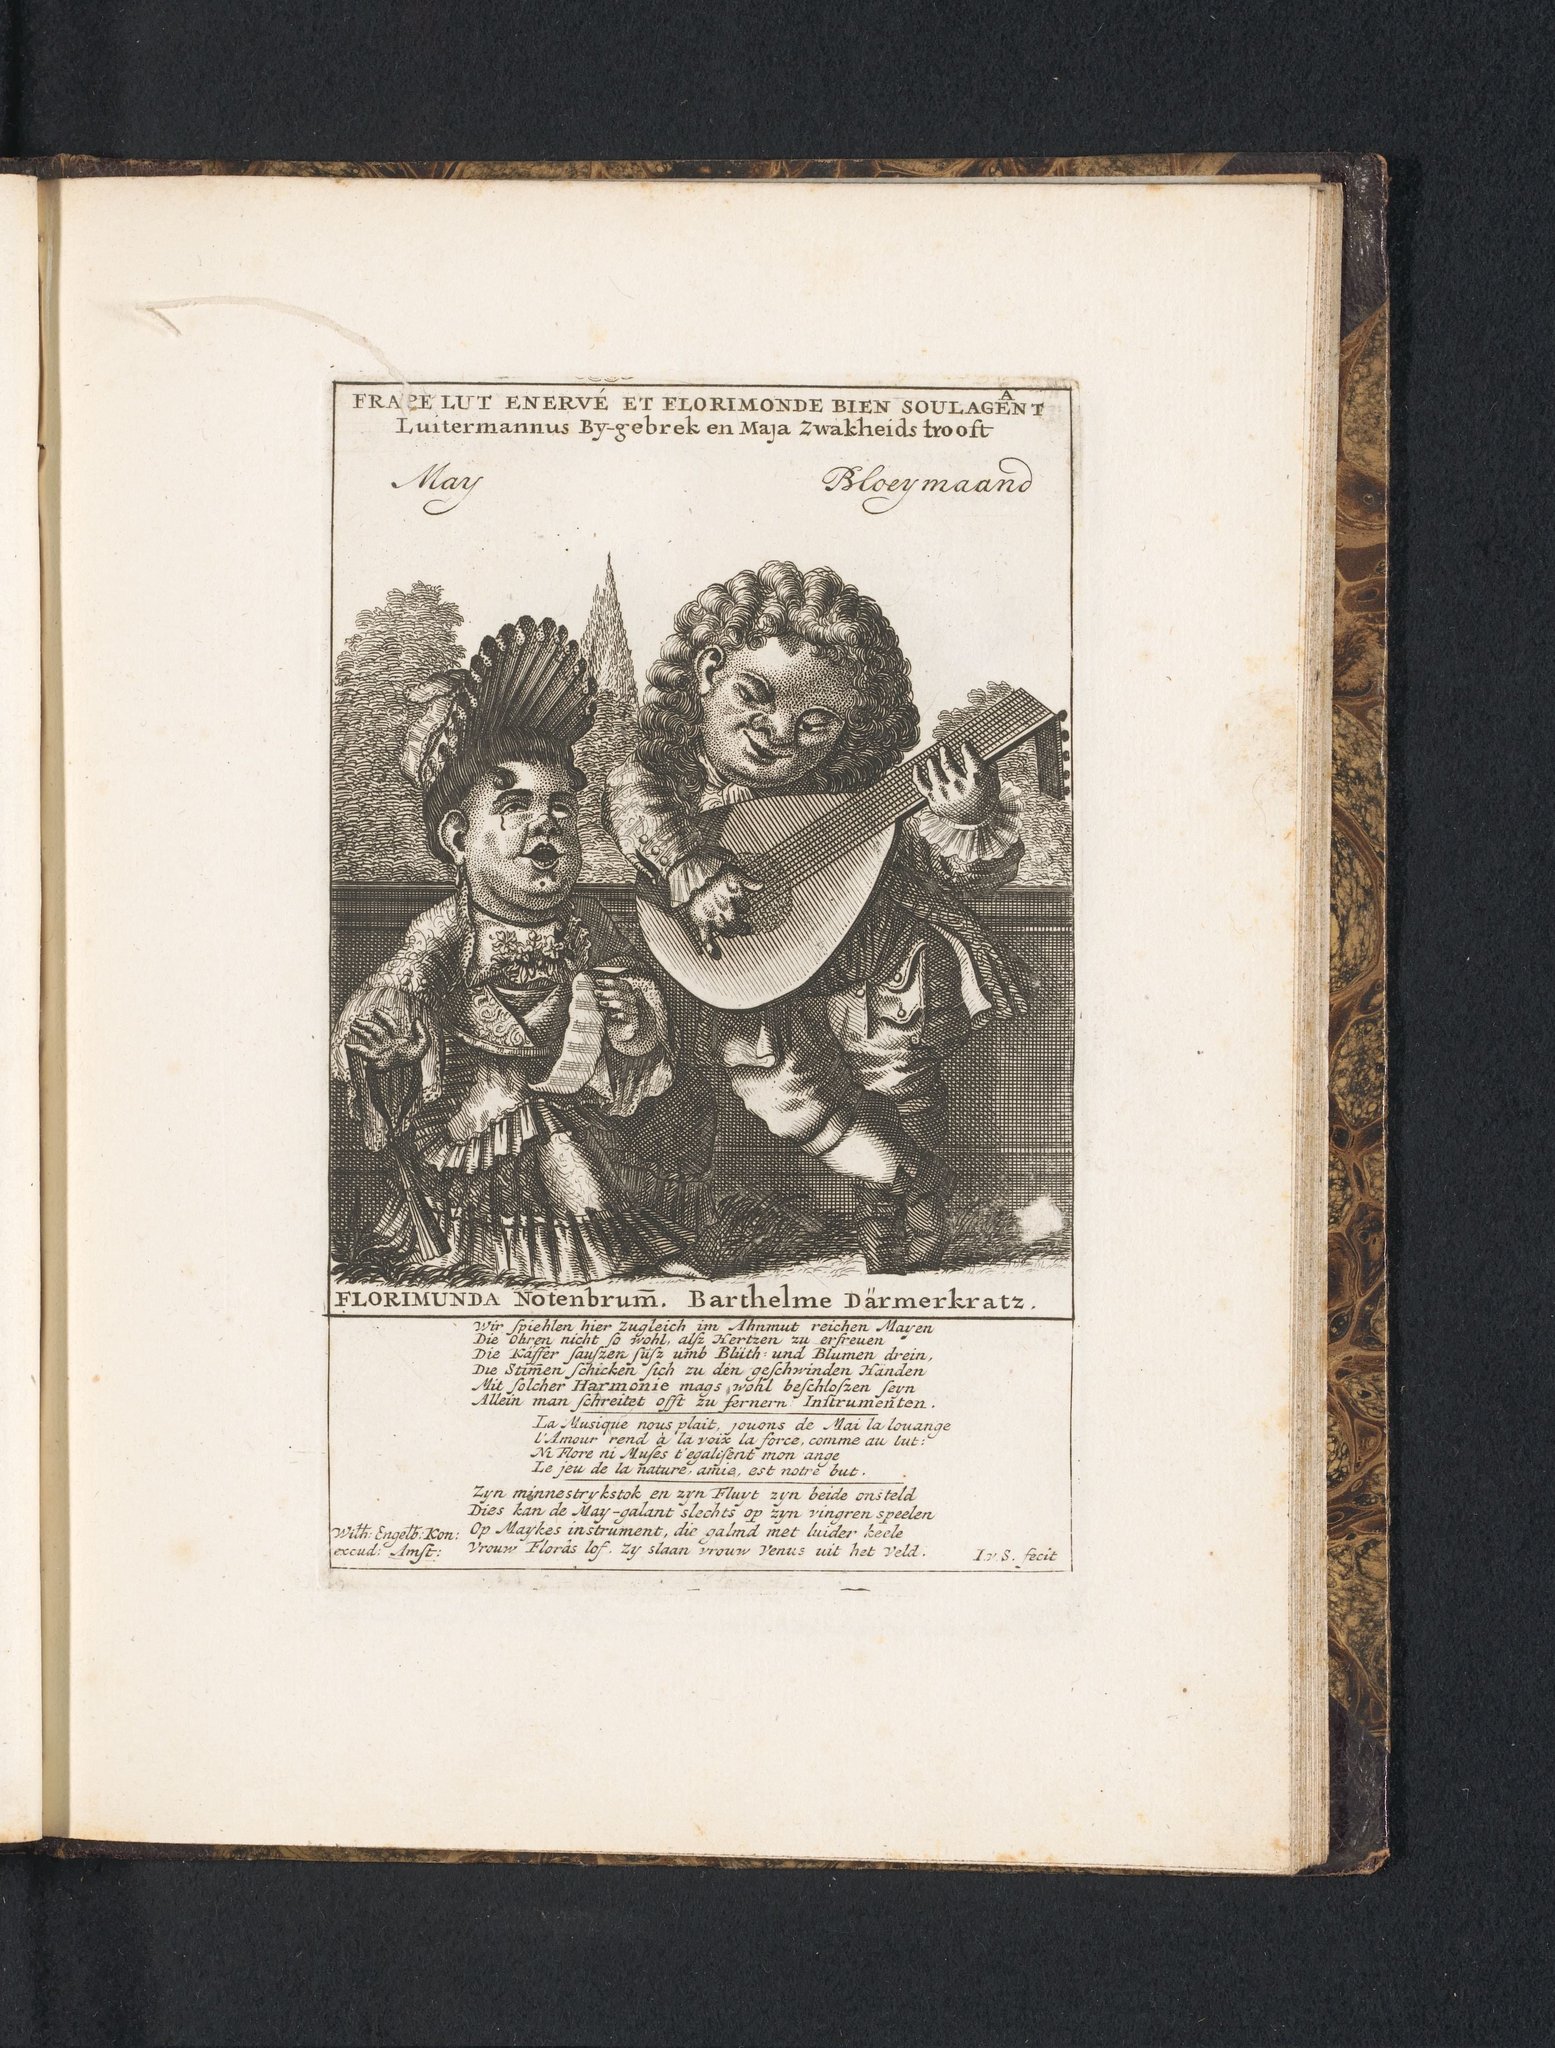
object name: print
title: Bombario Actionist en de Geest van Esopus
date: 1718-1720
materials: paper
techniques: engraving, etching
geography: northern netherlands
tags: caricatures (human types), little people, may and its 'labours'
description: Twee kleine mensen voor de maand mei (Bloeimaand). Man speelt op een luit en een zingende vrouw. In het onderschrift verzen in het Duits, Frans en Nederlands. Onderdeel van deel III (een serie van de twaalf maanden) in de tweede Nederlandse gebonden uitgave uit 1720 (en gerelateerd aan de Windhandel in dat jaar) van een serie karikaturen van kleine mensen, bekend als Het Dwergentooneel.